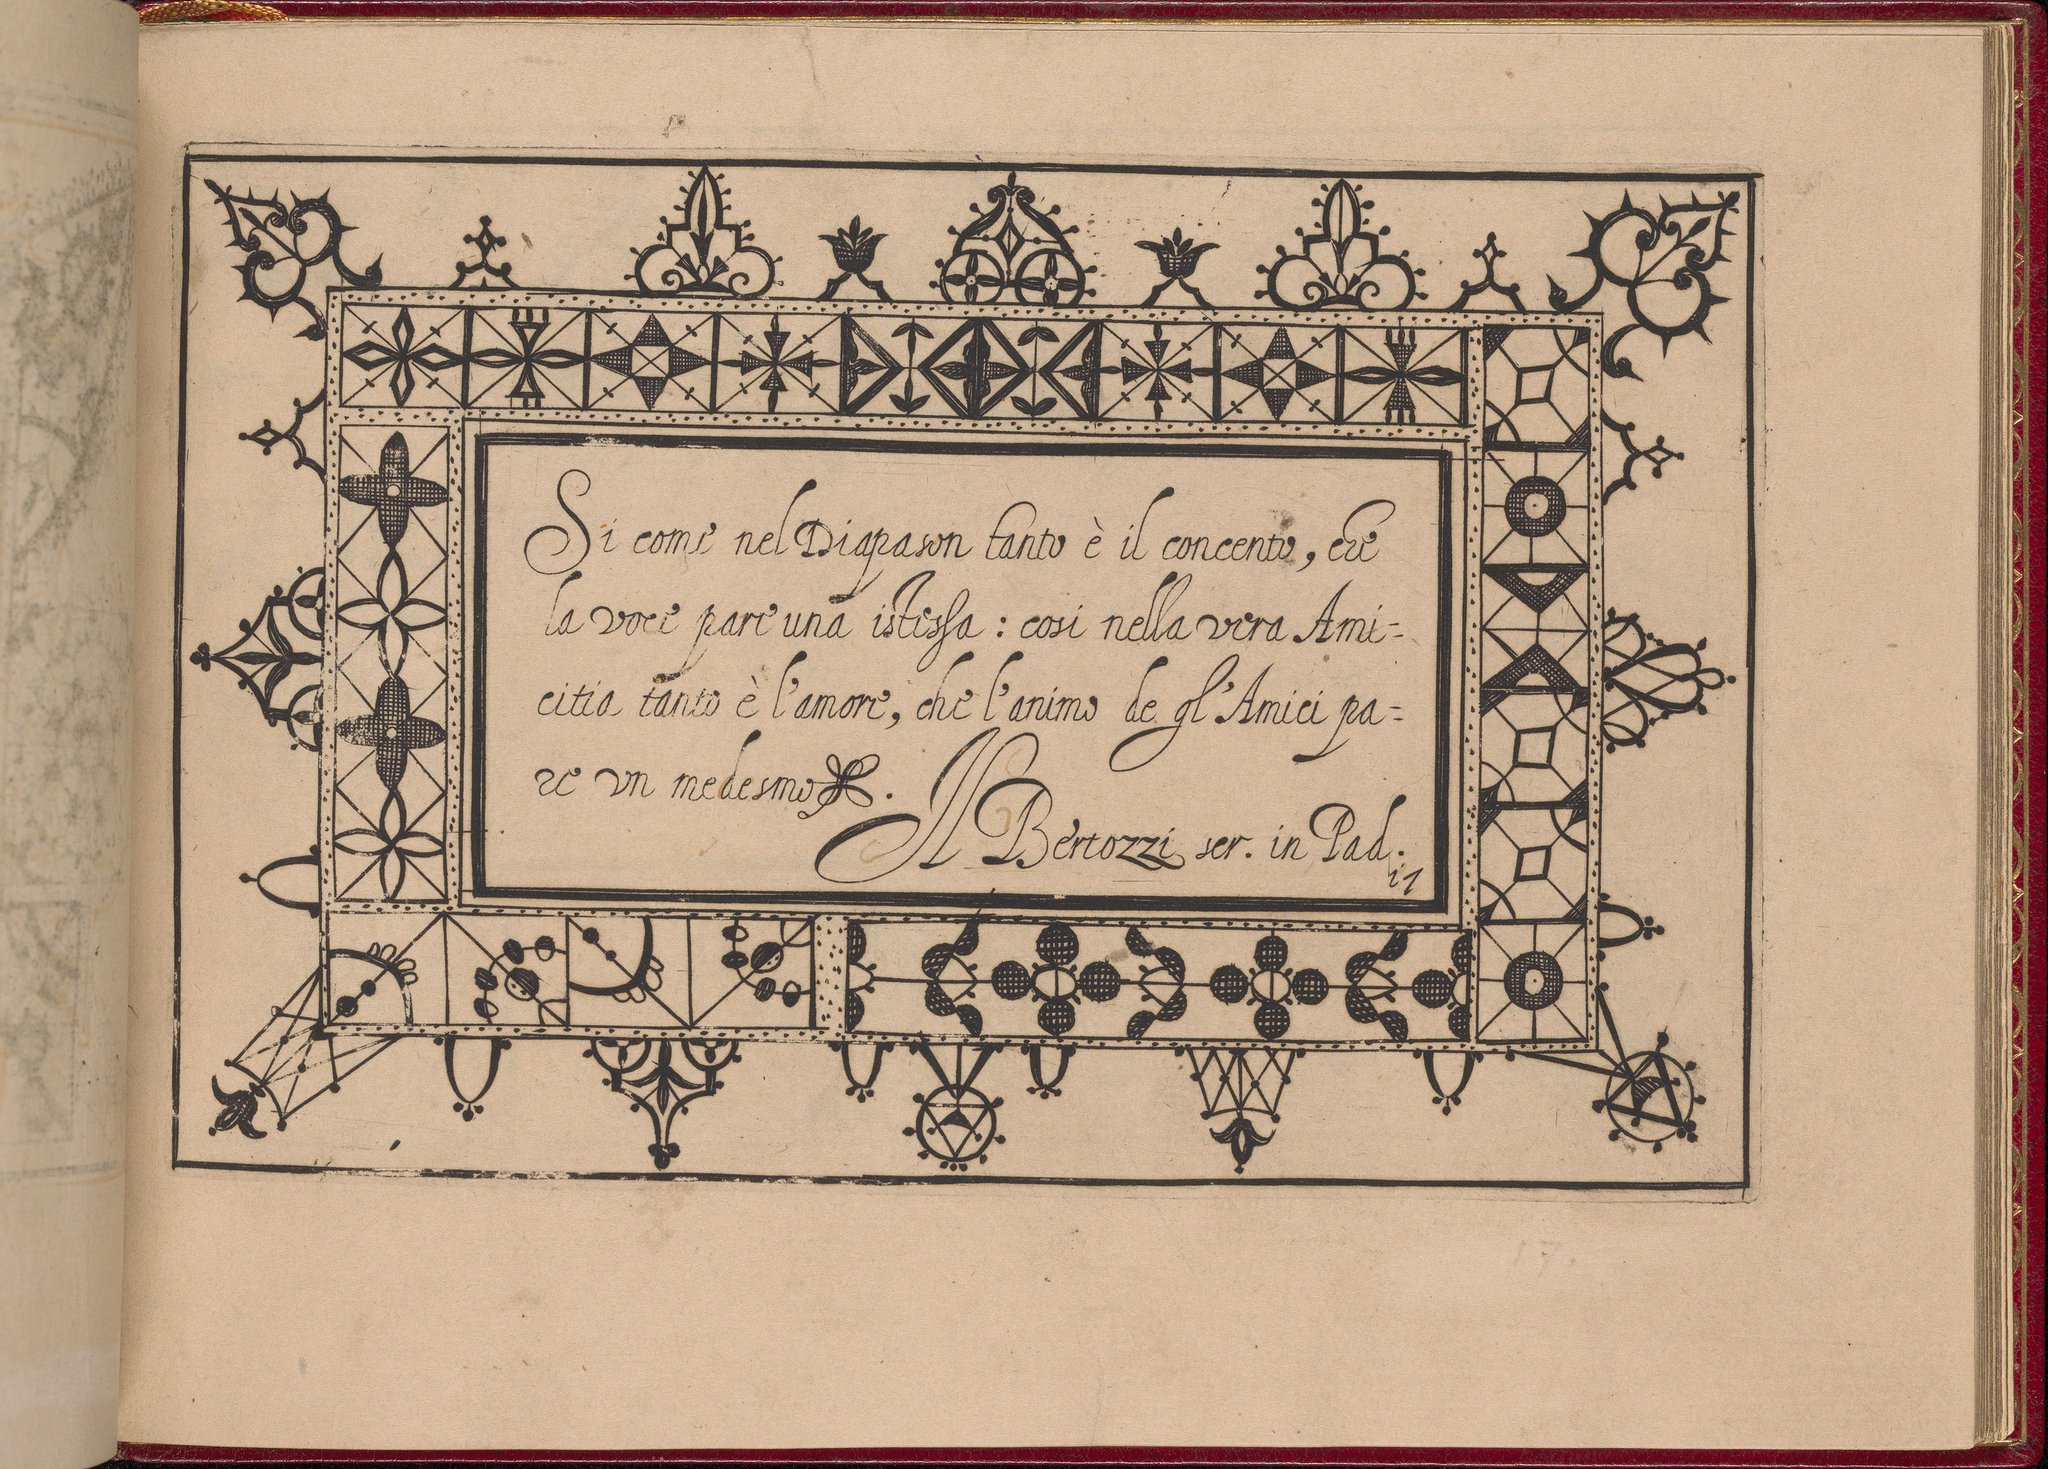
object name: book print ornament architecture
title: Ghirlanda: Di sei vaghi fiori scielti da piu famosi Giardini d'Italia, page 25 (recto)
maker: pietro paulo tozzi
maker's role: designer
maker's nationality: italian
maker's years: 1593-1628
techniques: drawing, etching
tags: ornament